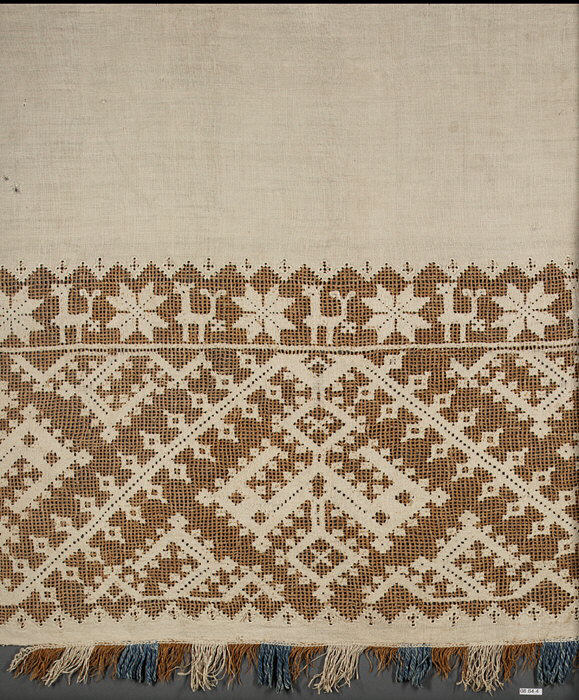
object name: border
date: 1601-1800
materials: linen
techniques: embroidery